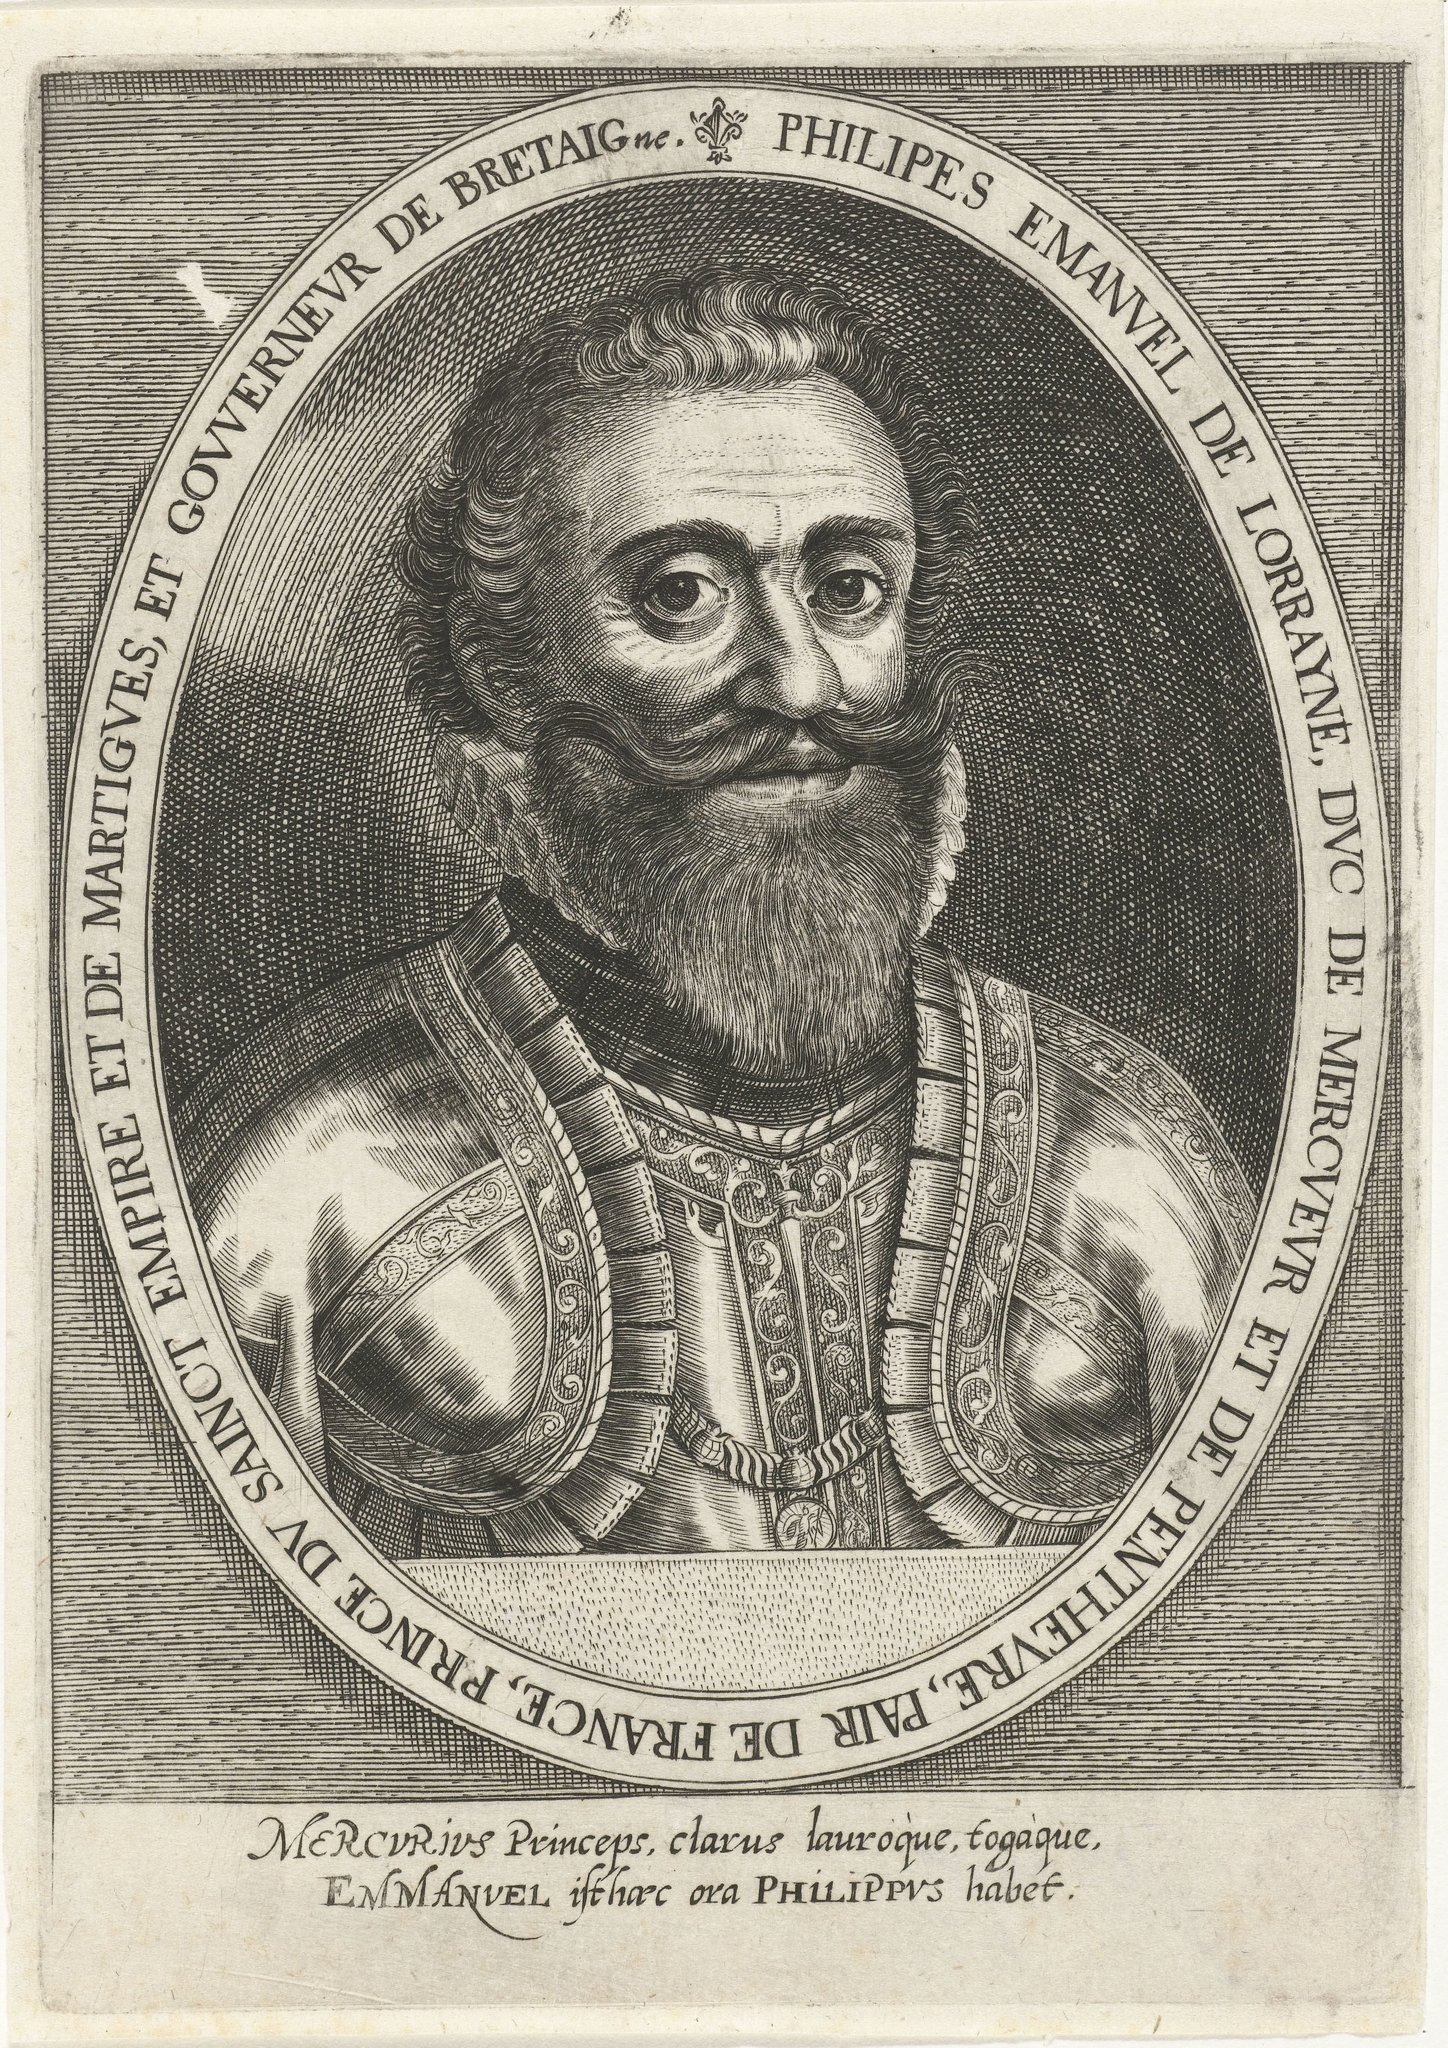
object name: print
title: Portretten van bekende personen uit de zestiende eeuw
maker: dominicus custos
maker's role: print maker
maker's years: 1560-1615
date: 1600-1604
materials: paper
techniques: engraving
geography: augsburg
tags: nancy, philippe-emmanuel de lorraine hertog van mercoeur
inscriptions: collector's mark: Lugt 240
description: Illustratie uit: D. Custos en M. Henning. Atrium heroicum Caesarum, regum aliorq. summatum ac procerum qui intra proximum seculum vixere, aut hodie supersunt, imaginib. Deel 1-4. Augsburg: D. Custos, 1600-1604.